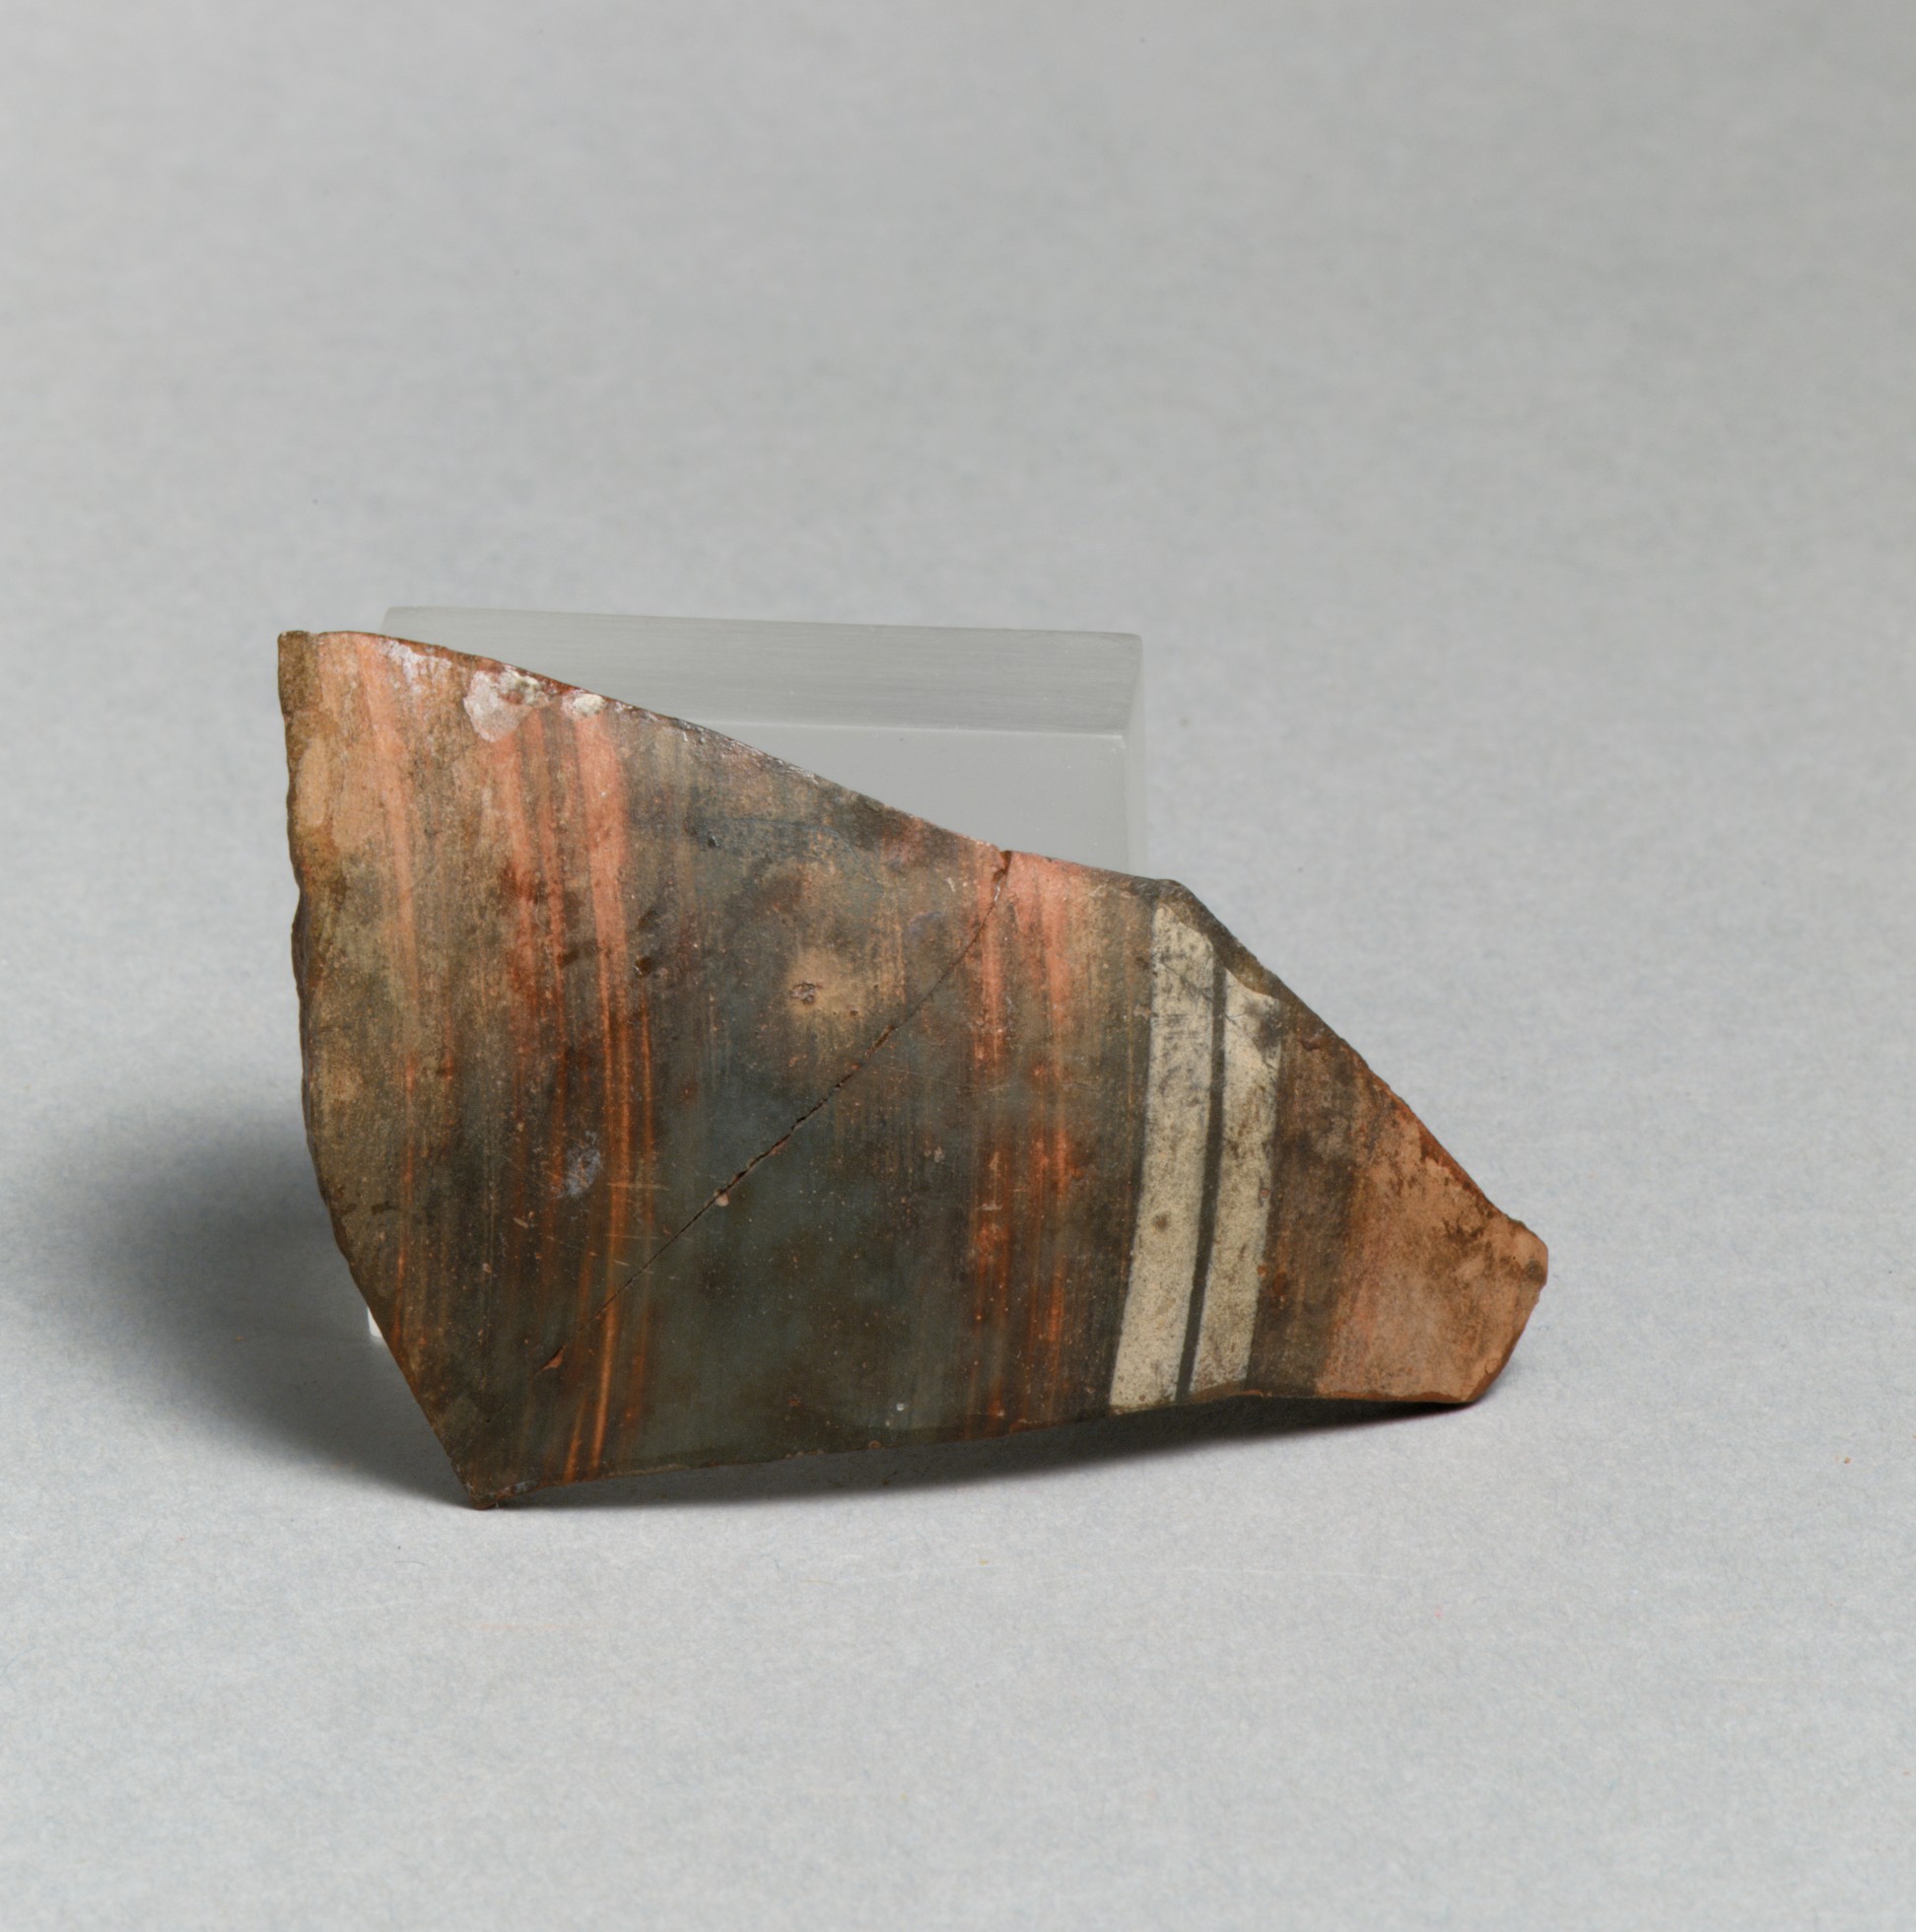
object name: vase fragment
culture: greek or lydian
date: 900-30 BCE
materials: terracotta